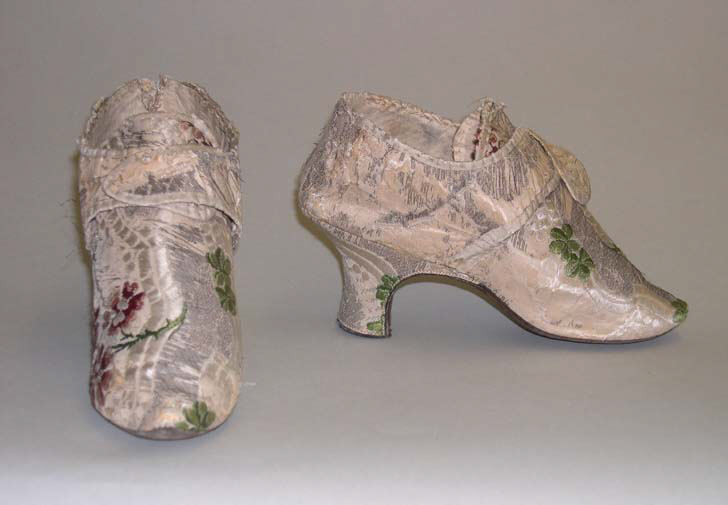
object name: shoe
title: Shoes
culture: european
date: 1760-1769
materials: leather, metal thread, silk, wood